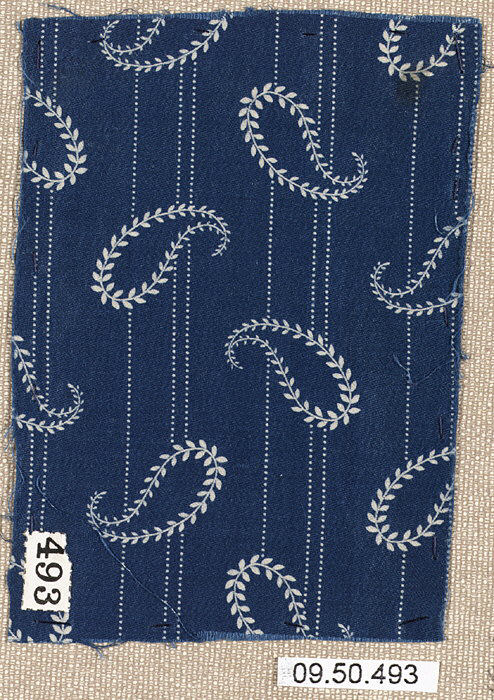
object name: piece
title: Piece (one of 13)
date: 1801-1900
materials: cotton